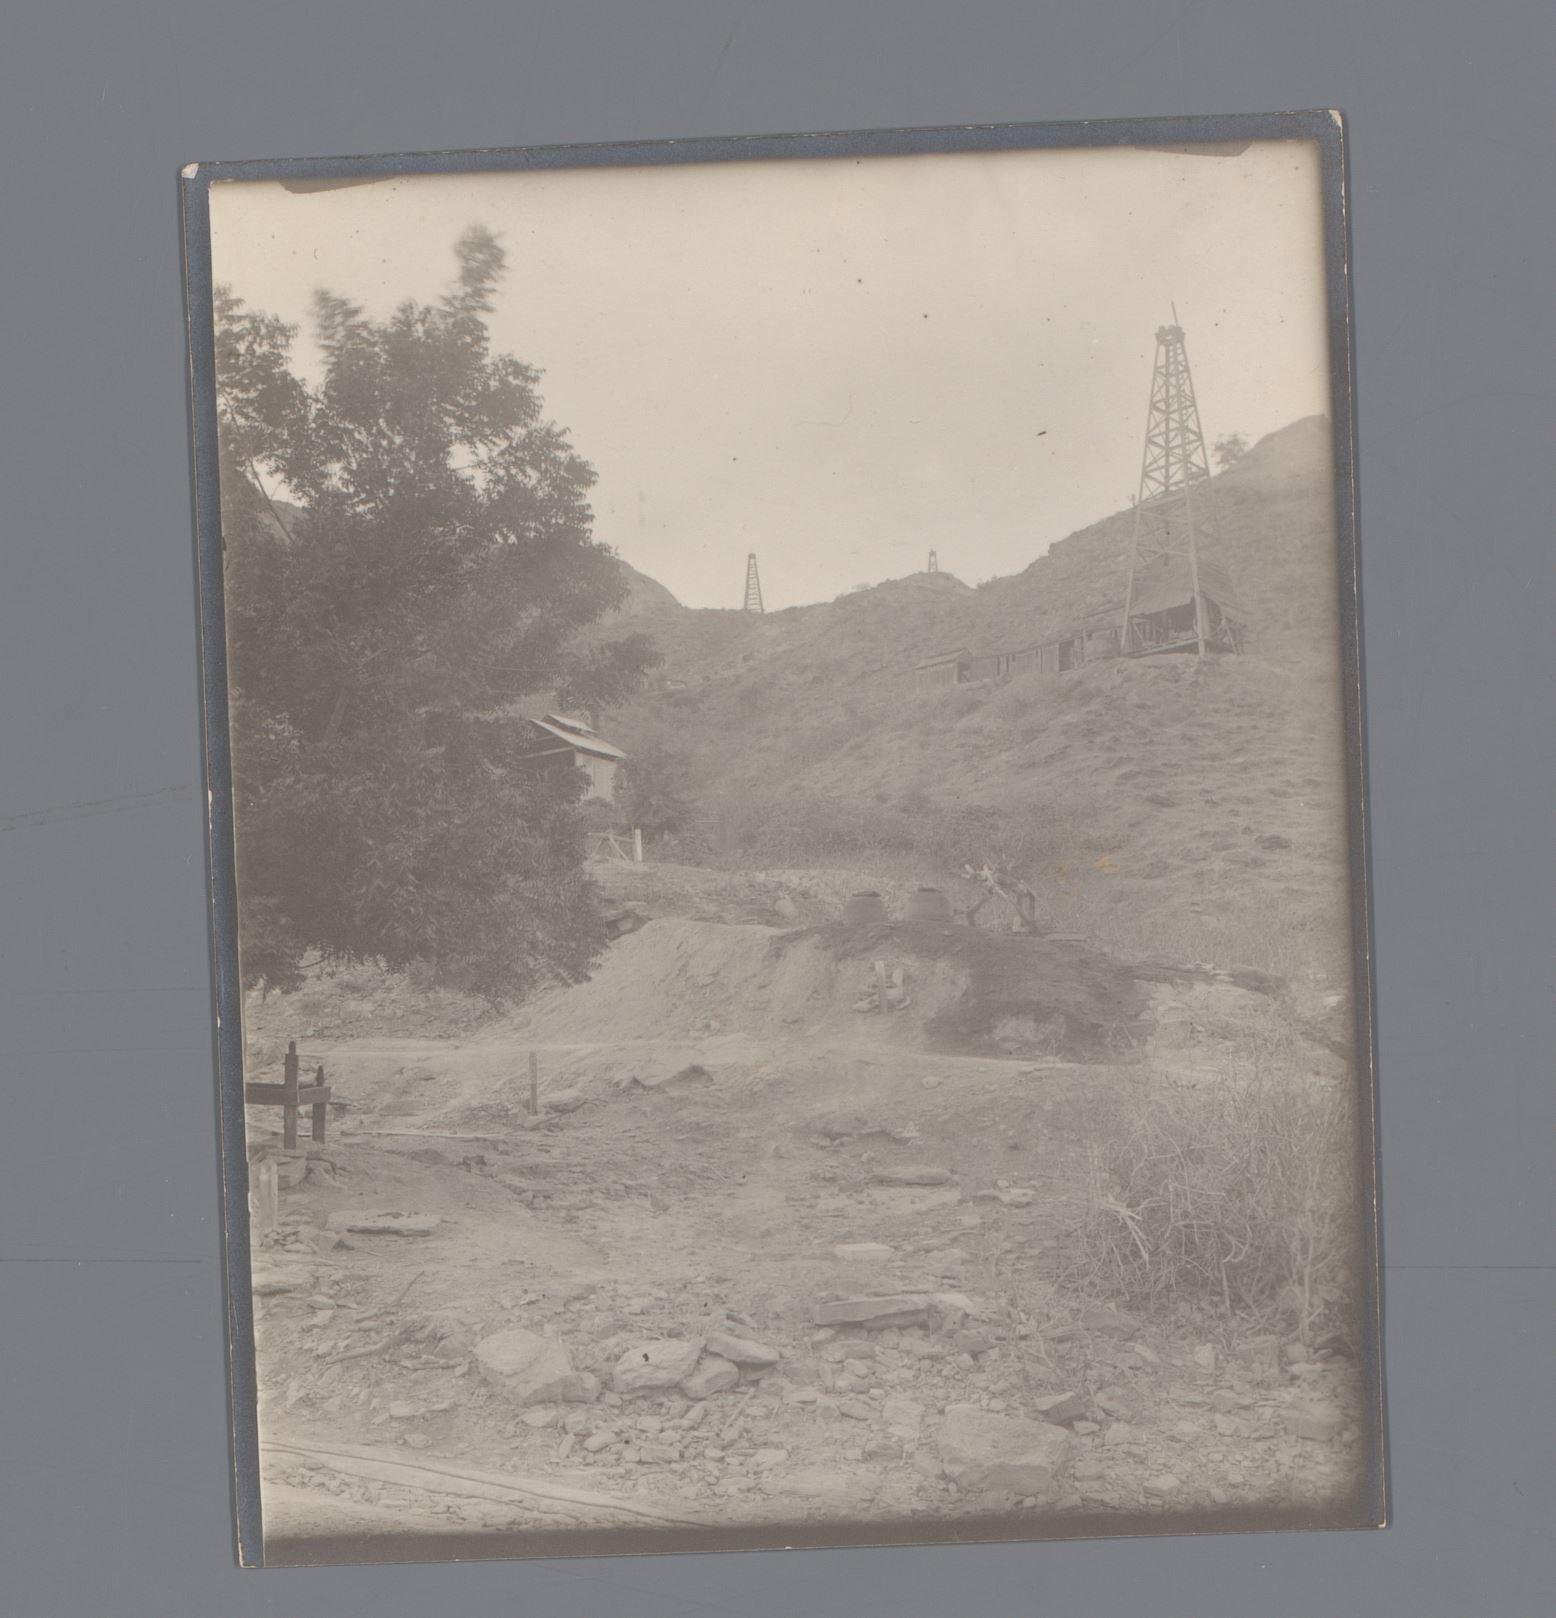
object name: photograph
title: Een mijngebied in de bergen, Zuid-Oost Azië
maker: jan adriani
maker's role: fotograaf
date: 1907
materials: photographic support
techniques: gelatin silver print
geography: southeast asia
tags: surface structures and surroundings of a mine, mountains